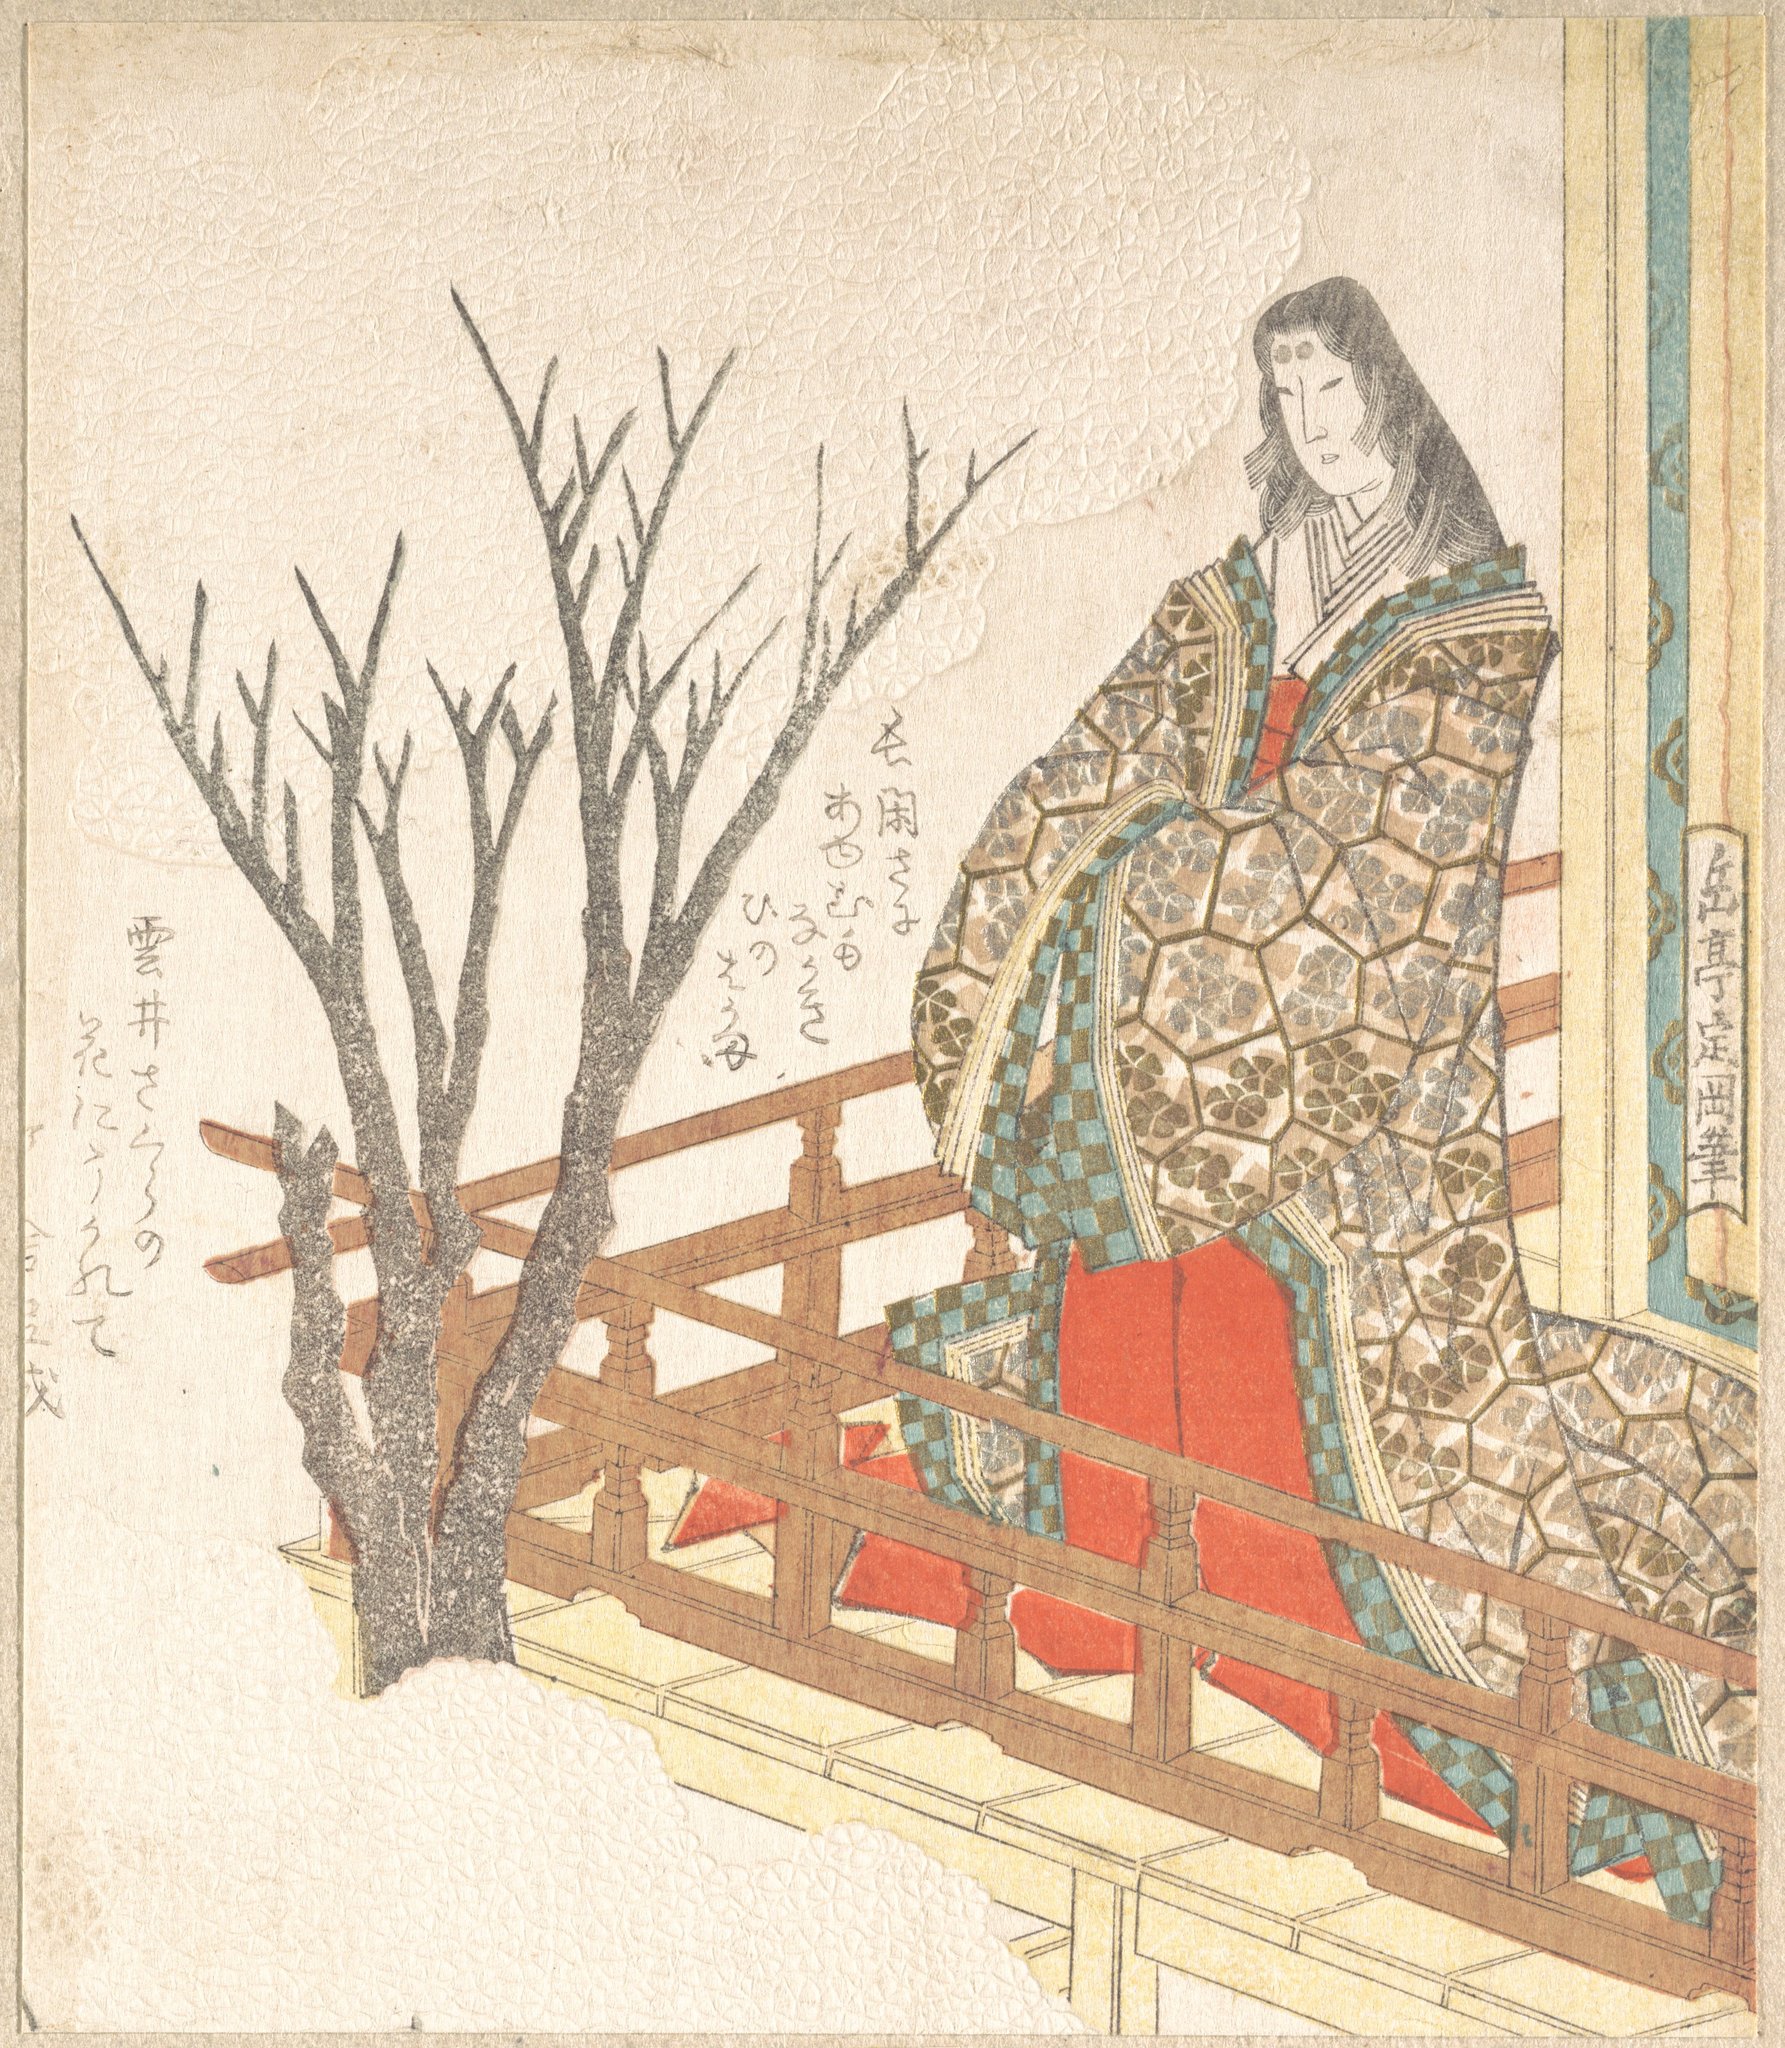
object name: print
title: Court Lady Looking at a Blooming Cherry-Tree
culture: japanese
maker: yashima gakutei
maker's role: artist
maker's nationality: japanese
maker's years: 1786-1868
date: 1801-1900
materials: ink, paper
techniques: surimono, woodblock print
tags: women,trees